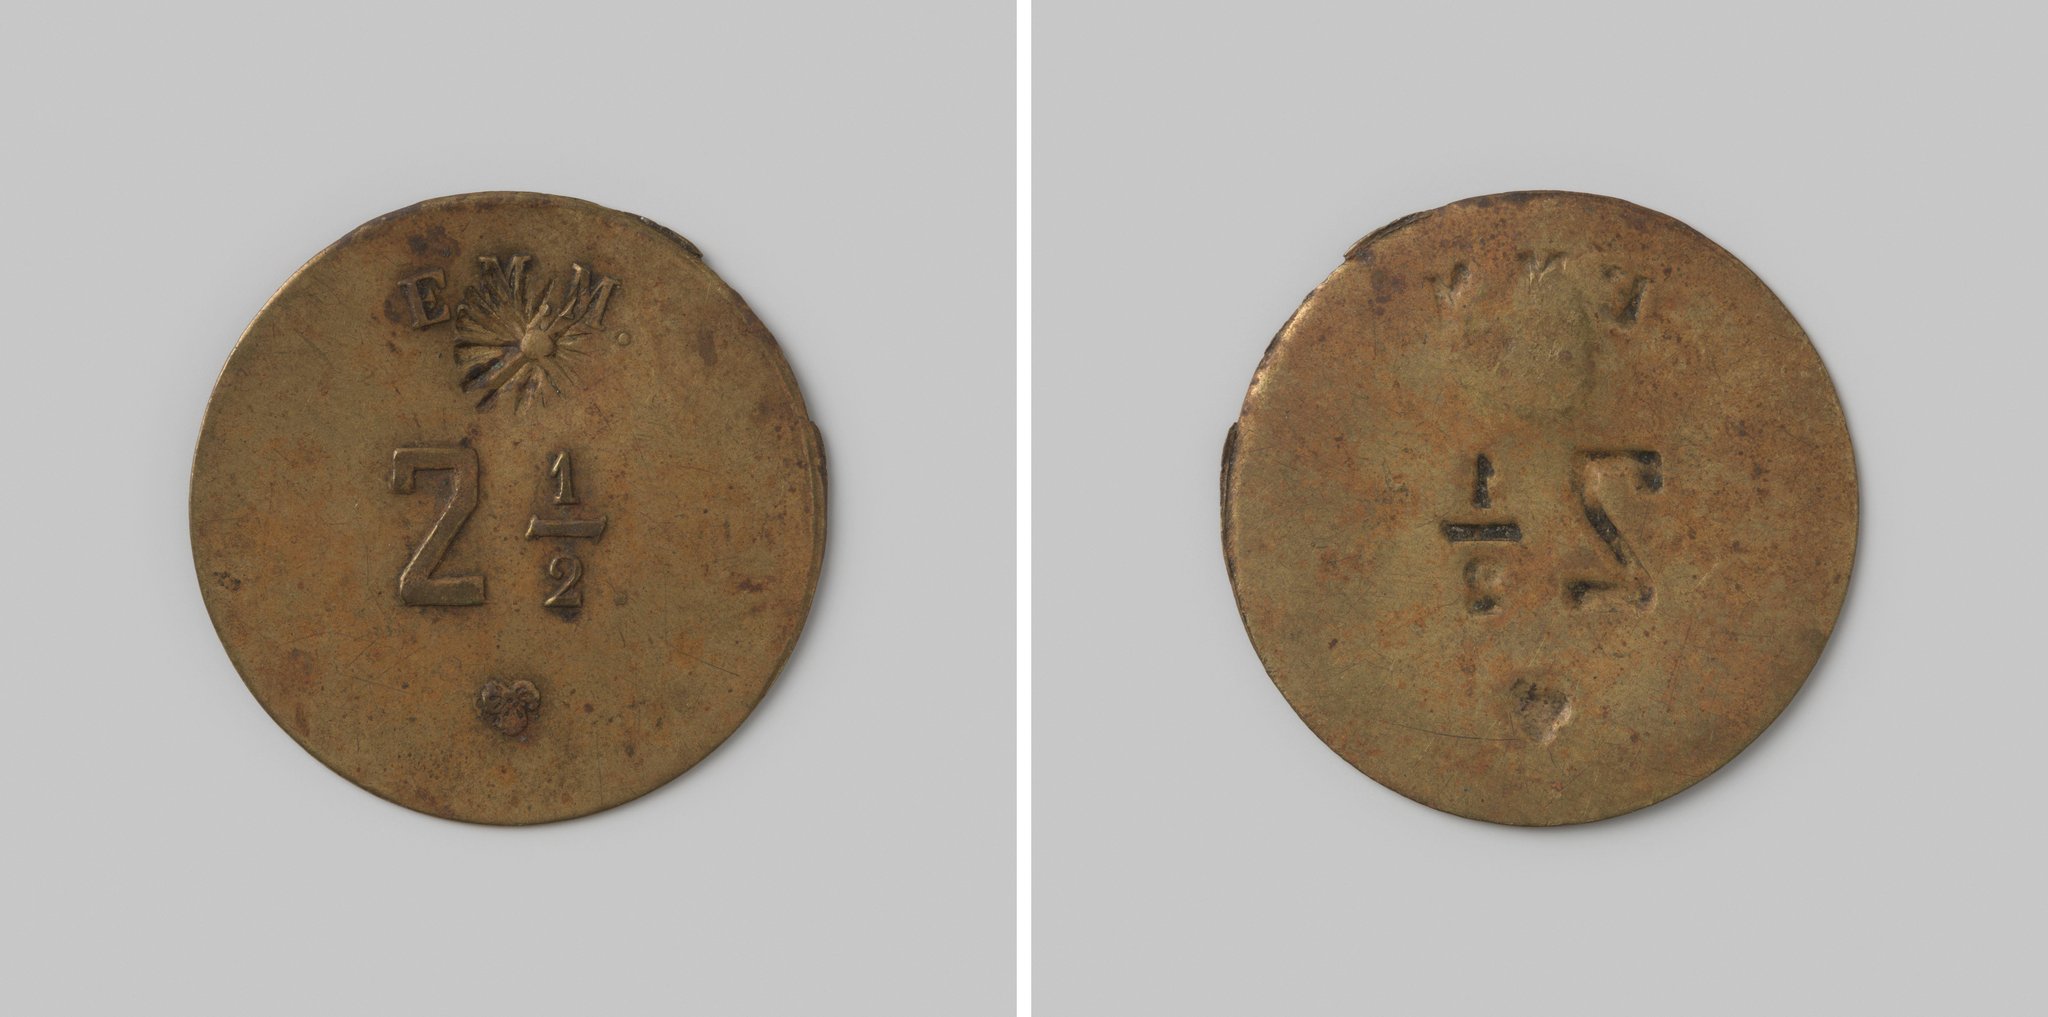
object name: history medal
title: Betaalpenning van 2½ cent van de Coöperatieve Winkelvereeniging Eendracht Maakt Magt te Hilversum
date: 1876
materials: brass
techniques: printing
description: Ronde messing penning met op de voorzijde de tekst 2½, boven E.M.M. en onder een bladmotief, ditzelfde incuus op de keerzijde. Op de voorzijde een ster ingestempeld.